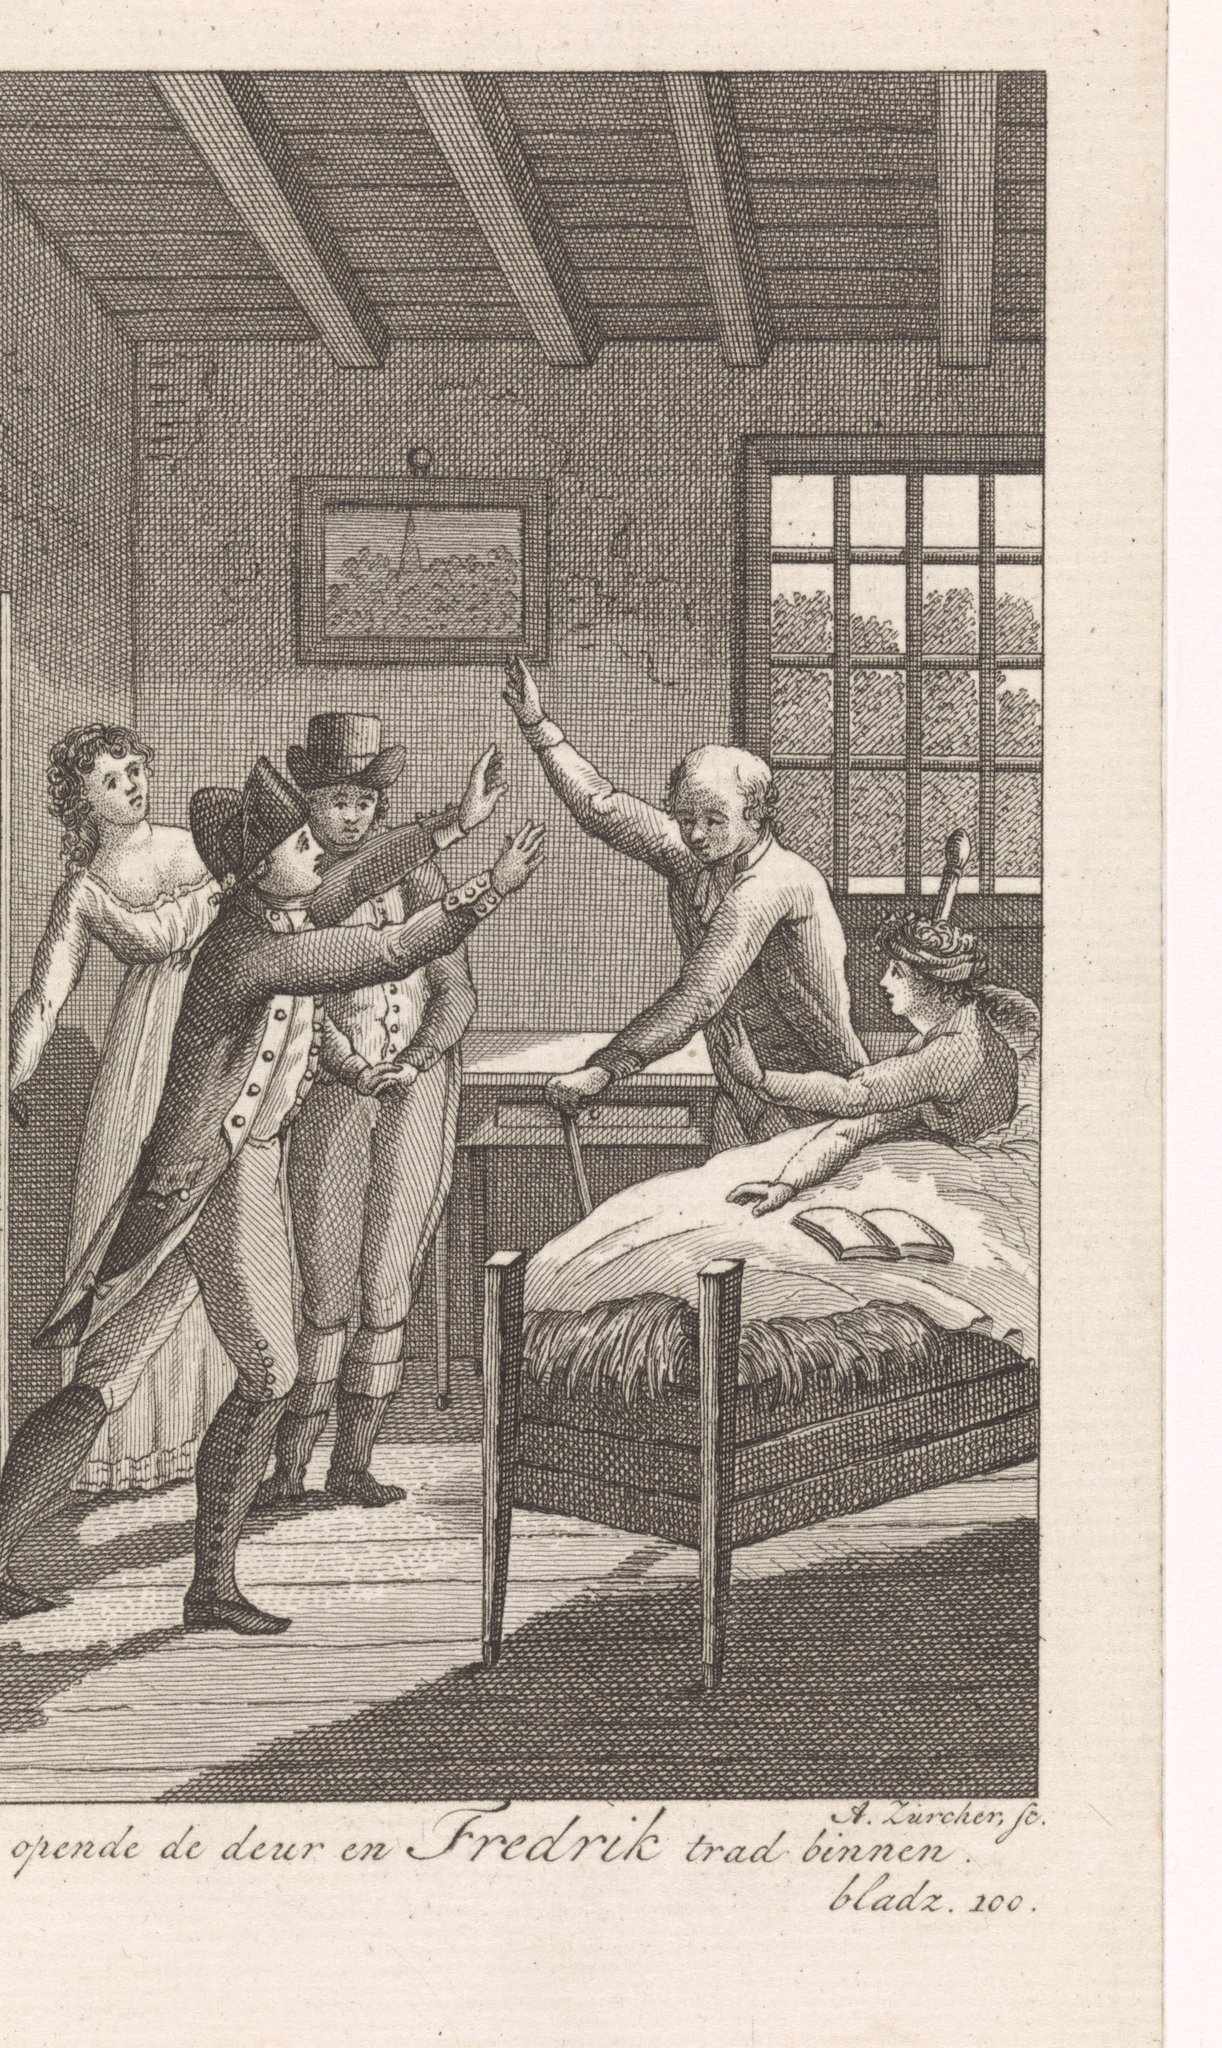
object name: print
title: Fredrik betreedt het huis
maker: antoni zürcher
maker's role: print maker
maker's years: 1754-1837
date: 1833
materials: paper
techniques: etching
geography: amsterdam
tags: interior of the house, saluting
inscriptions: collector's mark: Lugt 2760, collector's mark: Lugt 2228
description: Prent uit: Herrmann, Friedrich. Zedelijke verhalen voor kinderen van acht tot veertien jaren. Amsterdam: Schalekamp & Van de Grampel, 1833.